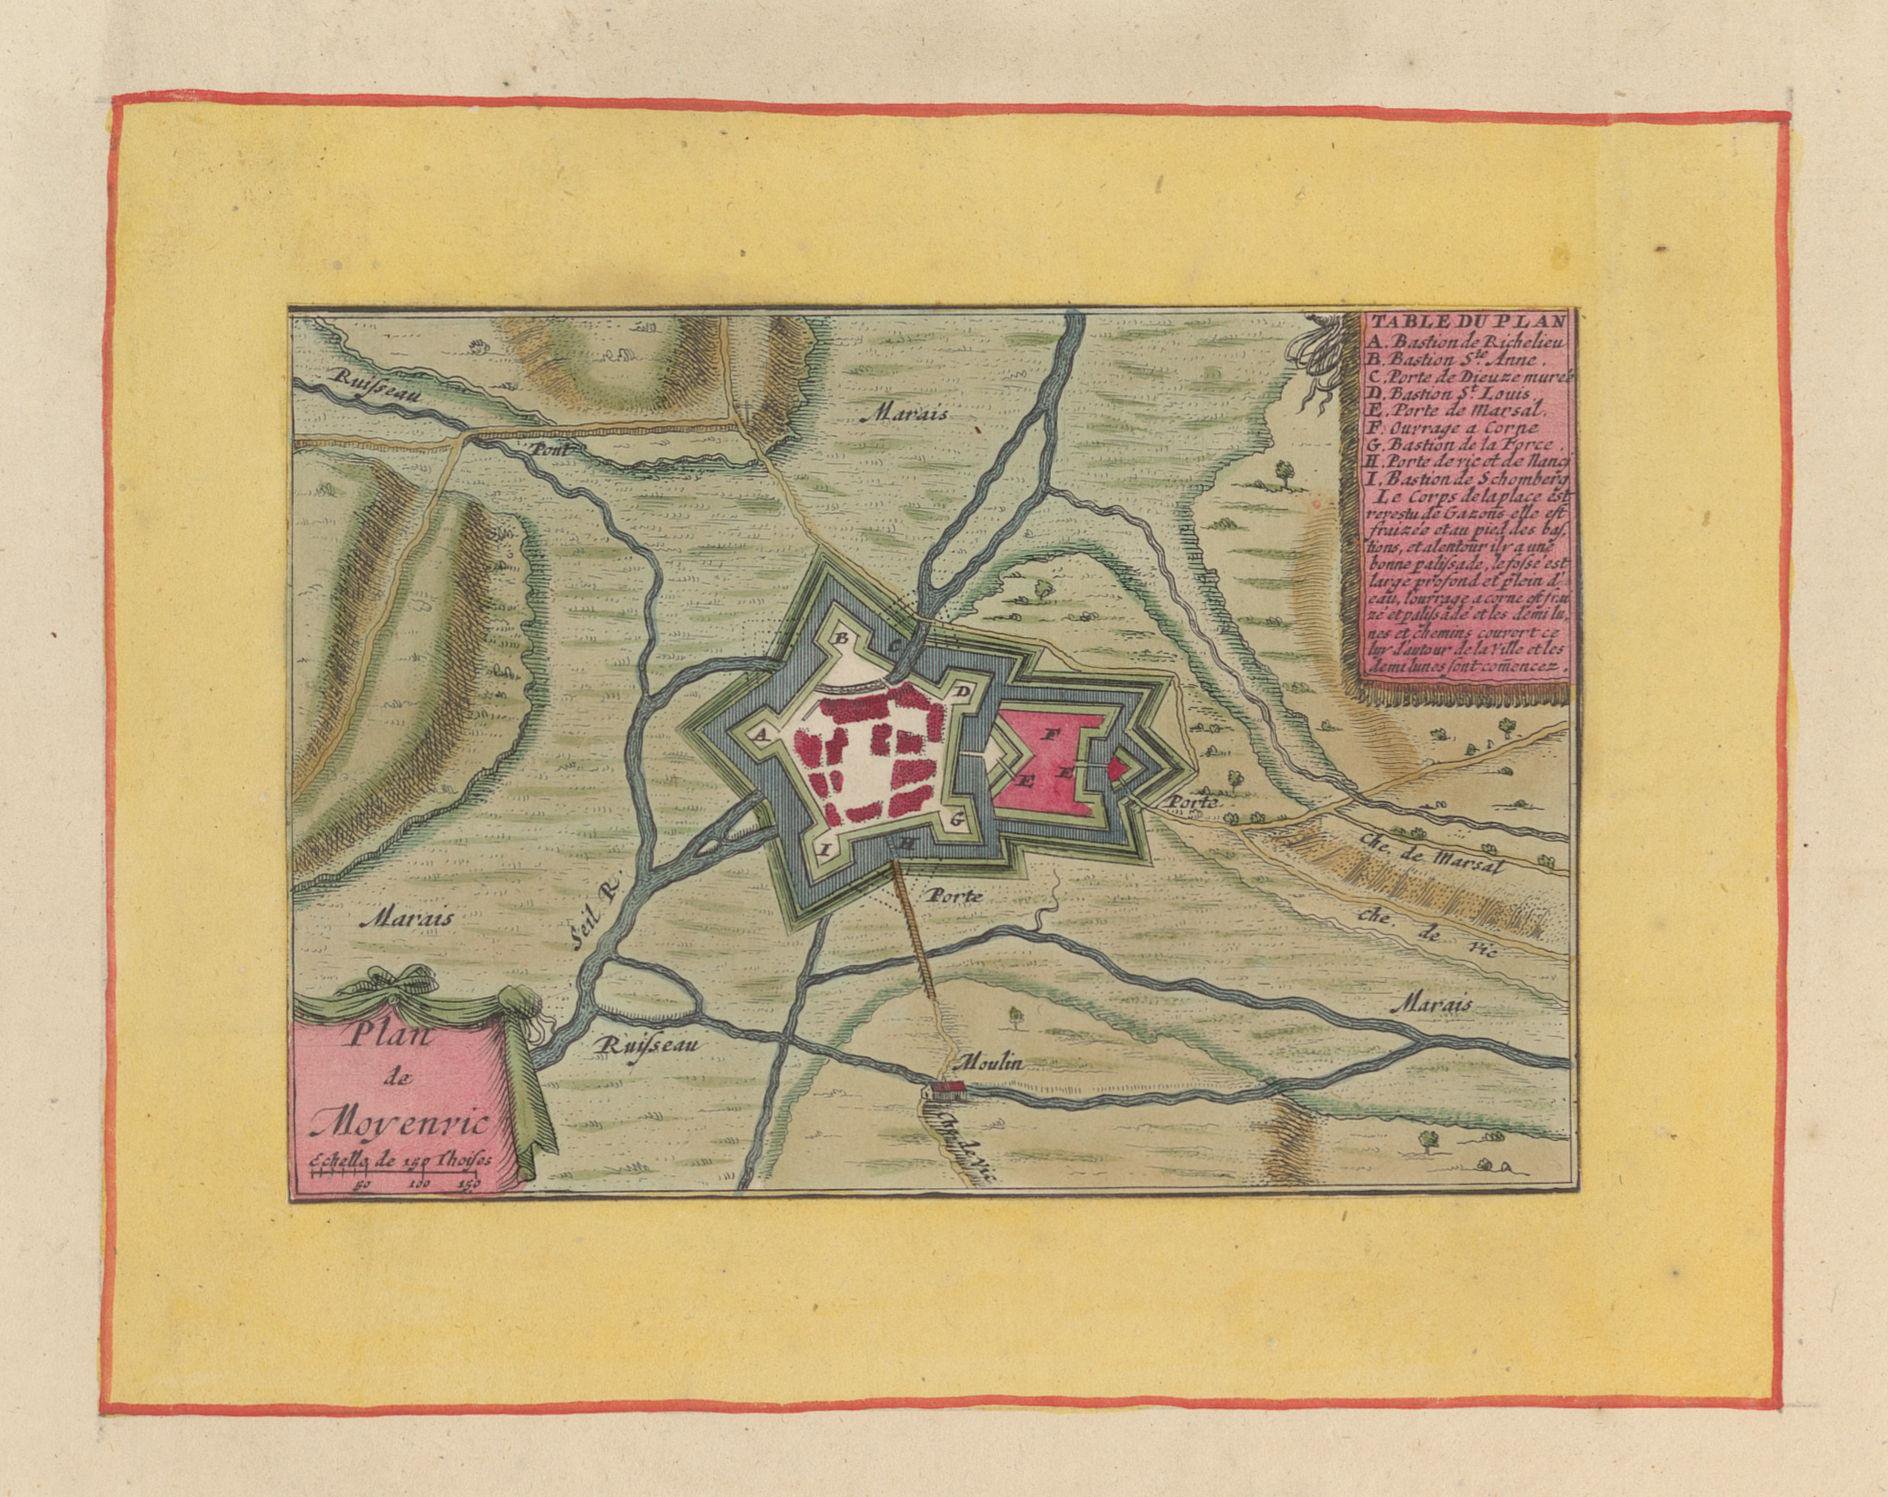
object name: print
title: Plattegrond van Moyenvic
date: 1700-1702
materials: paper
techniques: engraving, hand coloring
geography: the hague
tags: maps of cities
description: Deze plattegrond is in meerdere atlassen gebruikt. Onder andere in: Les forces de l'Europe. 10 dln. Amsterdam: Pieter Mortier, ca. 1700. En in: Les forces de l'Europe. 12 dln. Amsterdam: Pieter Mortier, 1702. Door het ontbreken van de marges van deze prent is onduidelijk om welke staat het gaat. Derhalve is niet te bepalen uit welke van deze publicaties dit exemplaar komt. Later is deze zelfde prent door Pieter van der Aa gebruikt in twee publicaties. Gezien het eind van de werkzame periode van de inkleurder van de prenten in dit album is het niet mogelijk dat deze prent uit een van die publicaties komt.